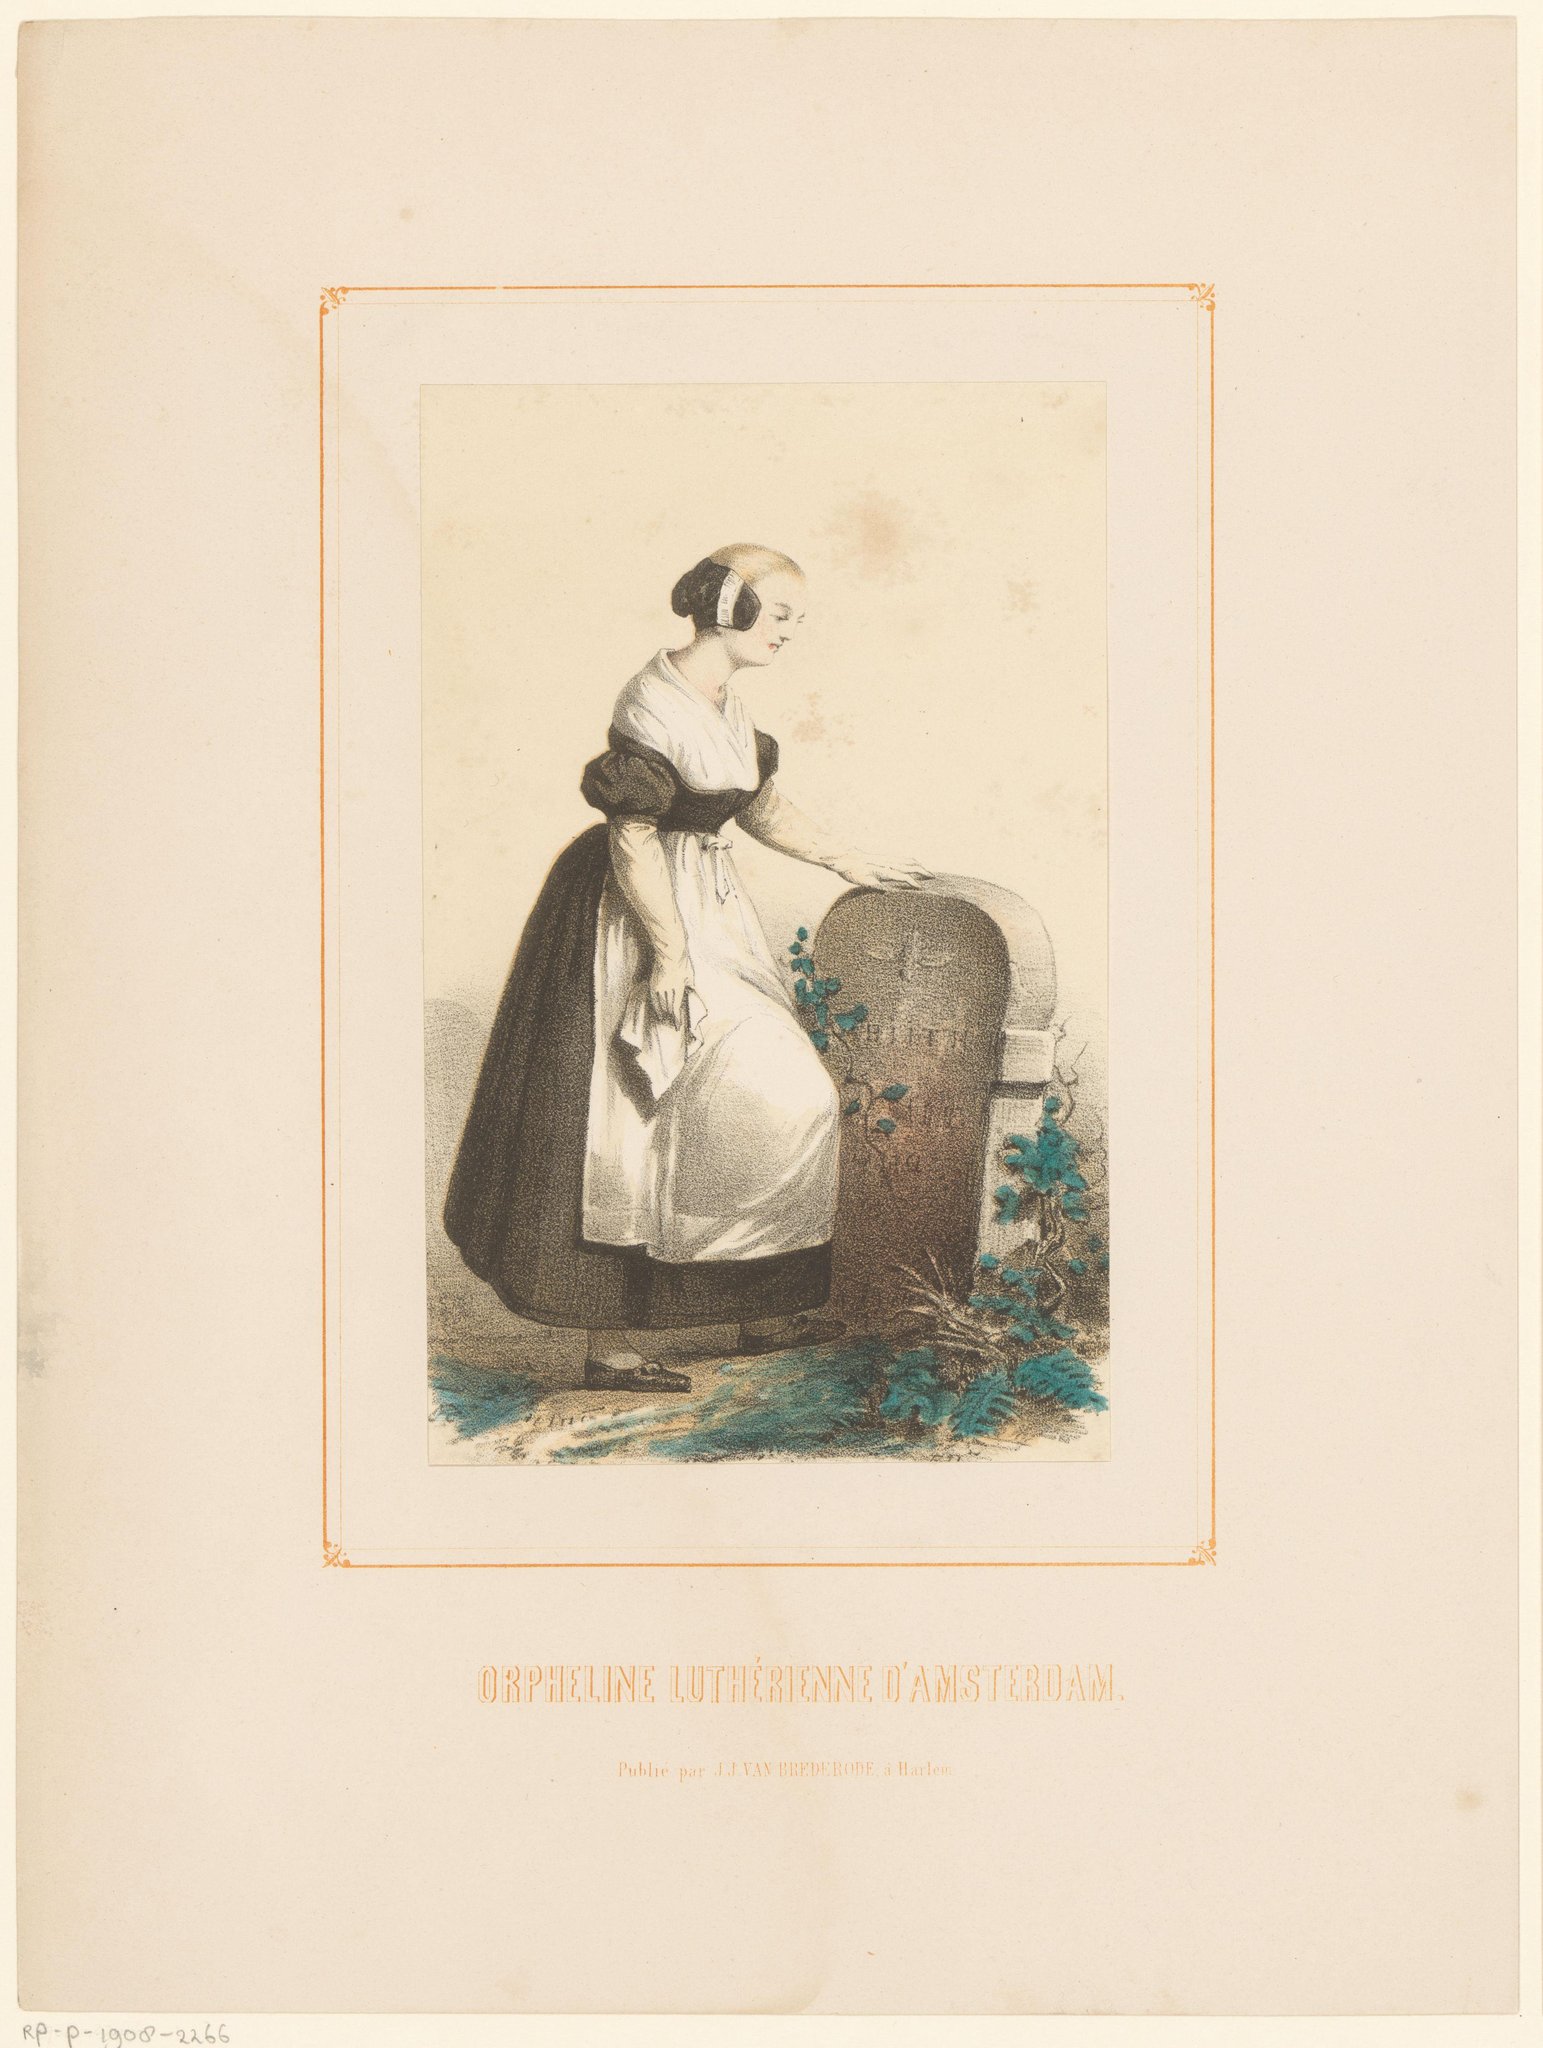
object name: print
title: Orpheline Luthérienne d'Amsterdam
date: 1849-1873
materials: paper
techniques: lithograph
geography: haarlem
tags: handkerchief, folk costume, regional costume, gravestone, tombstone, orphans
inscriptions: collector's mark: Lugt 2228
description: Het meisje heeft een zakdoek in haar rechterhand.